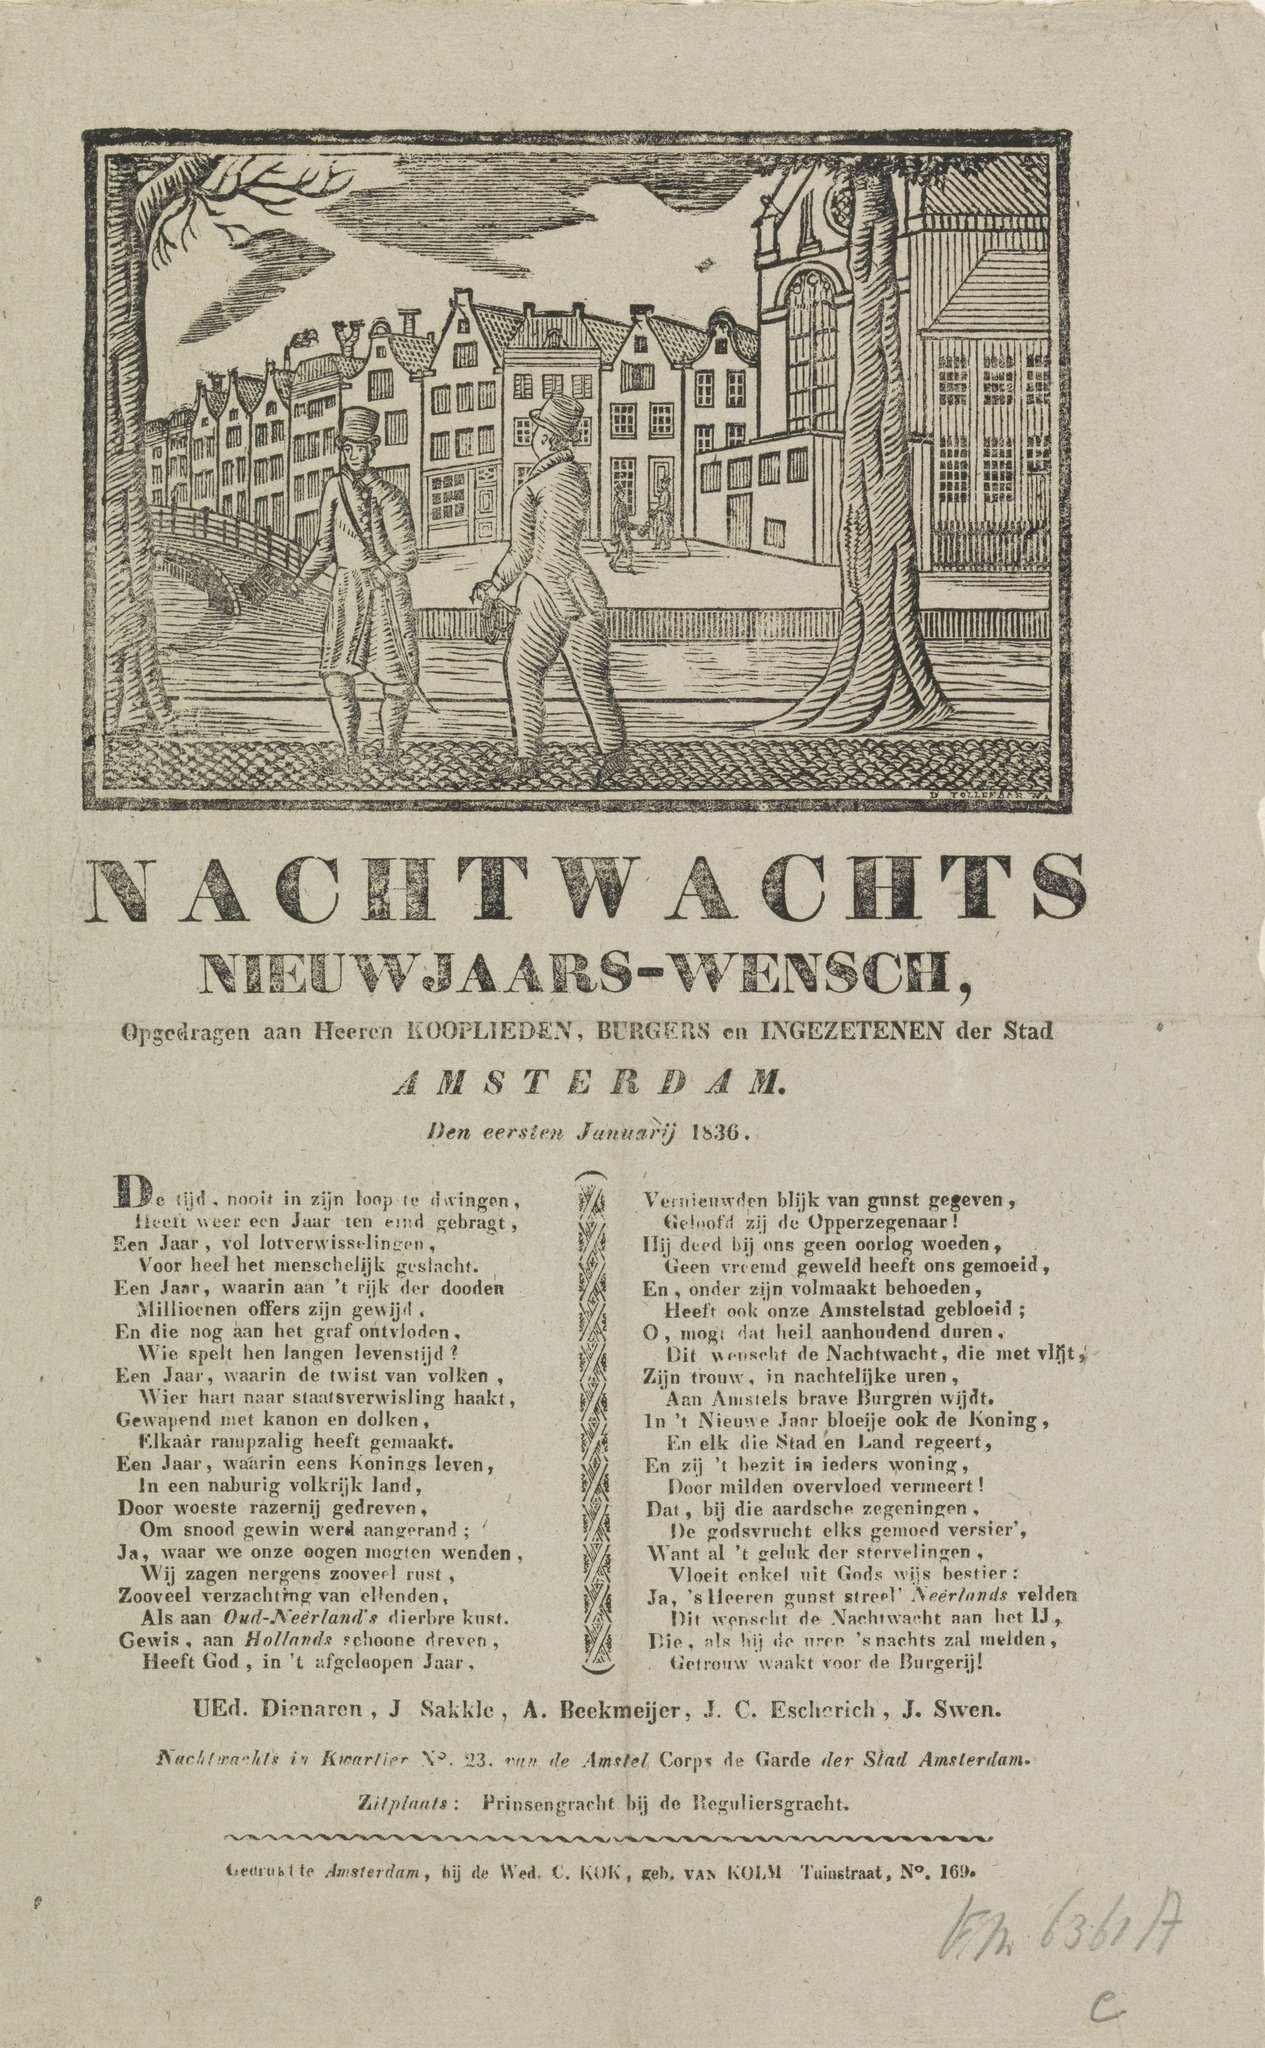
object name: new year card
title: Nieuwjaarswens van de Amsterdamse nachtwacht voor het jaar 1836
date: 1835-1836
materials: paper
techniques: letterpress printing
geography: netherlands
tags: night patrol, street, amsterdam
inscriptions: collector's mark: Lugt 2228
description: Nieuwjaarswens van de Amsterdamse nachtwacht (ratelwacht) voor het jaar 1836. Twee leden van de nachtwacht lopend met een ratel bij het Amstelveld in Amsterdam. Met een vers in twee kolommen. Namens de nachtwacht in kwartier No. 23 van de Amstel Corps de Garde der stad Amsterdam: J. Sakkle, A. Beekmeijer, J.C. Escherich en J. Swen.